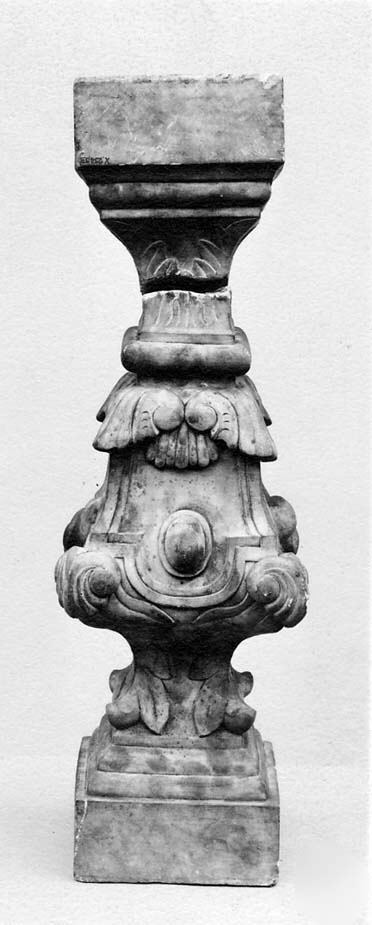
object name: baluster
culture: chinese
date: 1601-1800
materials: marble